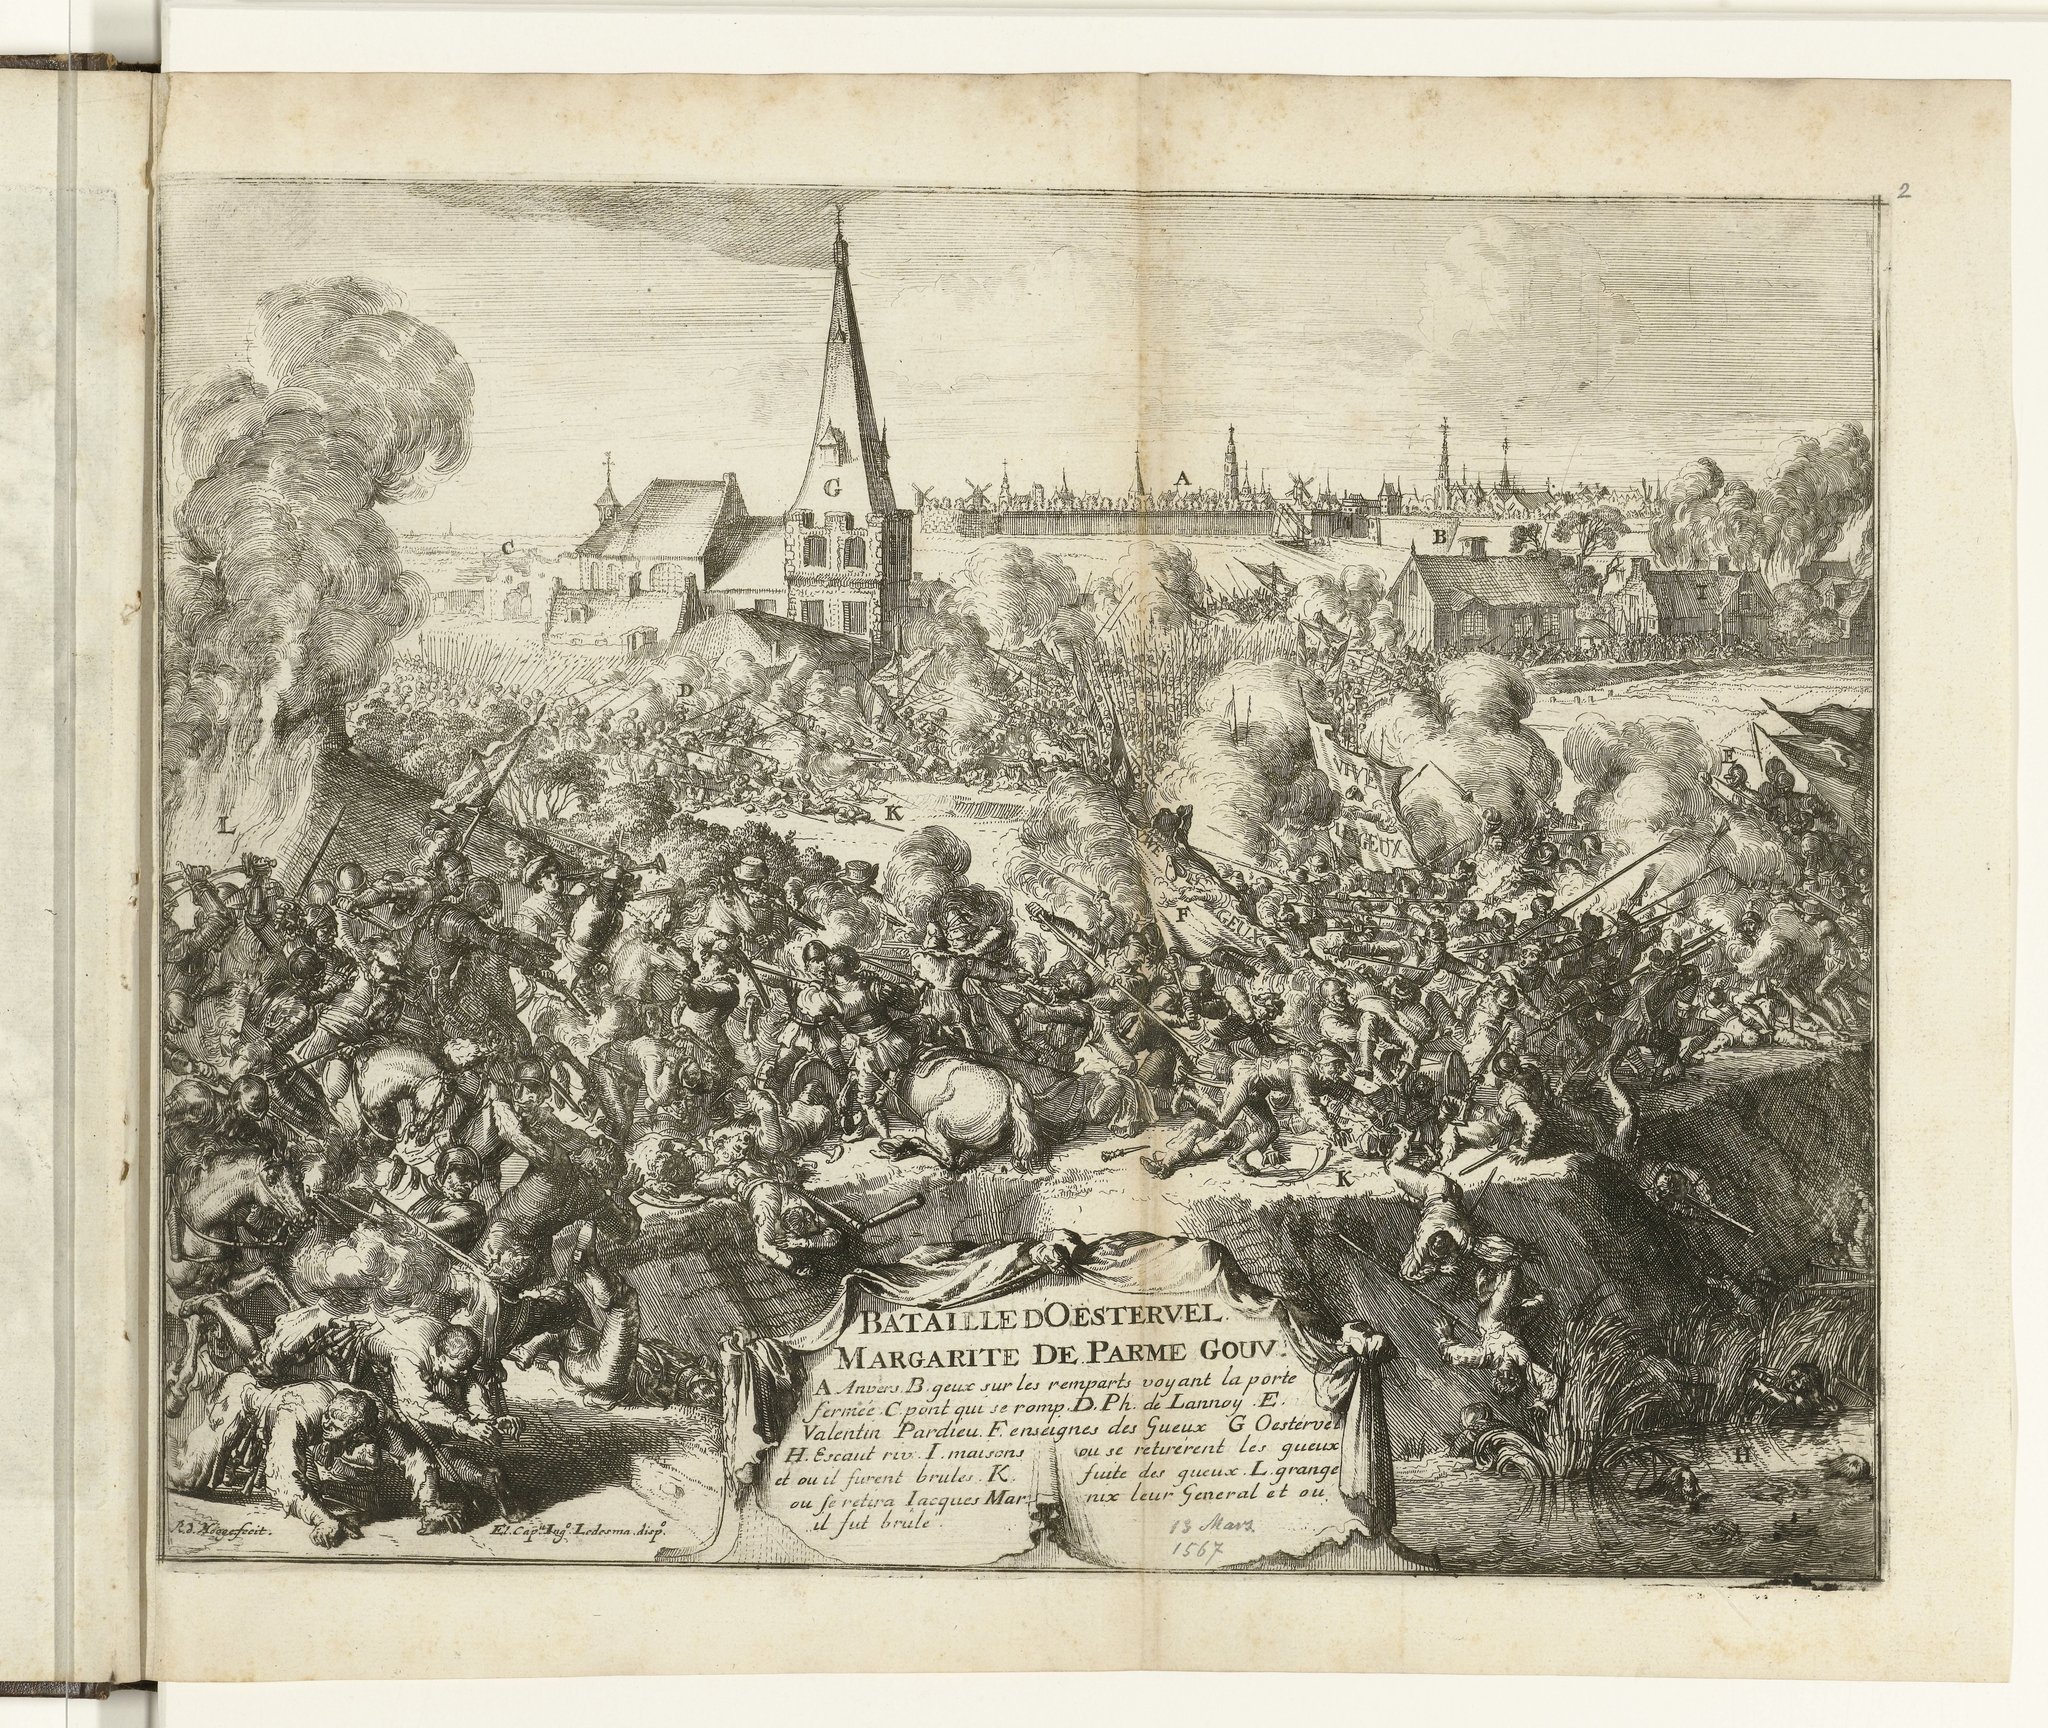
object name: print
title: Bataille d'Oestervel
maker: romeyn de hooghe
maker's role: draughtsman, goldsmith, painter, print maker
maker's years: 1645-1708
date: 1670-1699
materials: paper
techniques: etching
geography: netherlands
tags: battle, fighting in general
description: Waarschijnlijk oorspronkelijk vervaardigd voor een uitgave van Histoire de la guerre de Flandre, van F. Strada, eind 17e eeuw. De prent is onderdeel van een bundel van prenten en portretten getiteld Des Guerres de Flandres, in drie delen, met in totaal 22 batailles, 6 portretten en 3 titelprenten voor de afzonderlijke delen, alles (behalve de portretten) door De Hooghe en Ledesma in één band, ongenummerd en zonder titelblad (zie Rijksmuseum Research Library, inv.nr. BI-1929-10, 329 C 20). De prenten hebben betrekking op de periode 1567-1592.